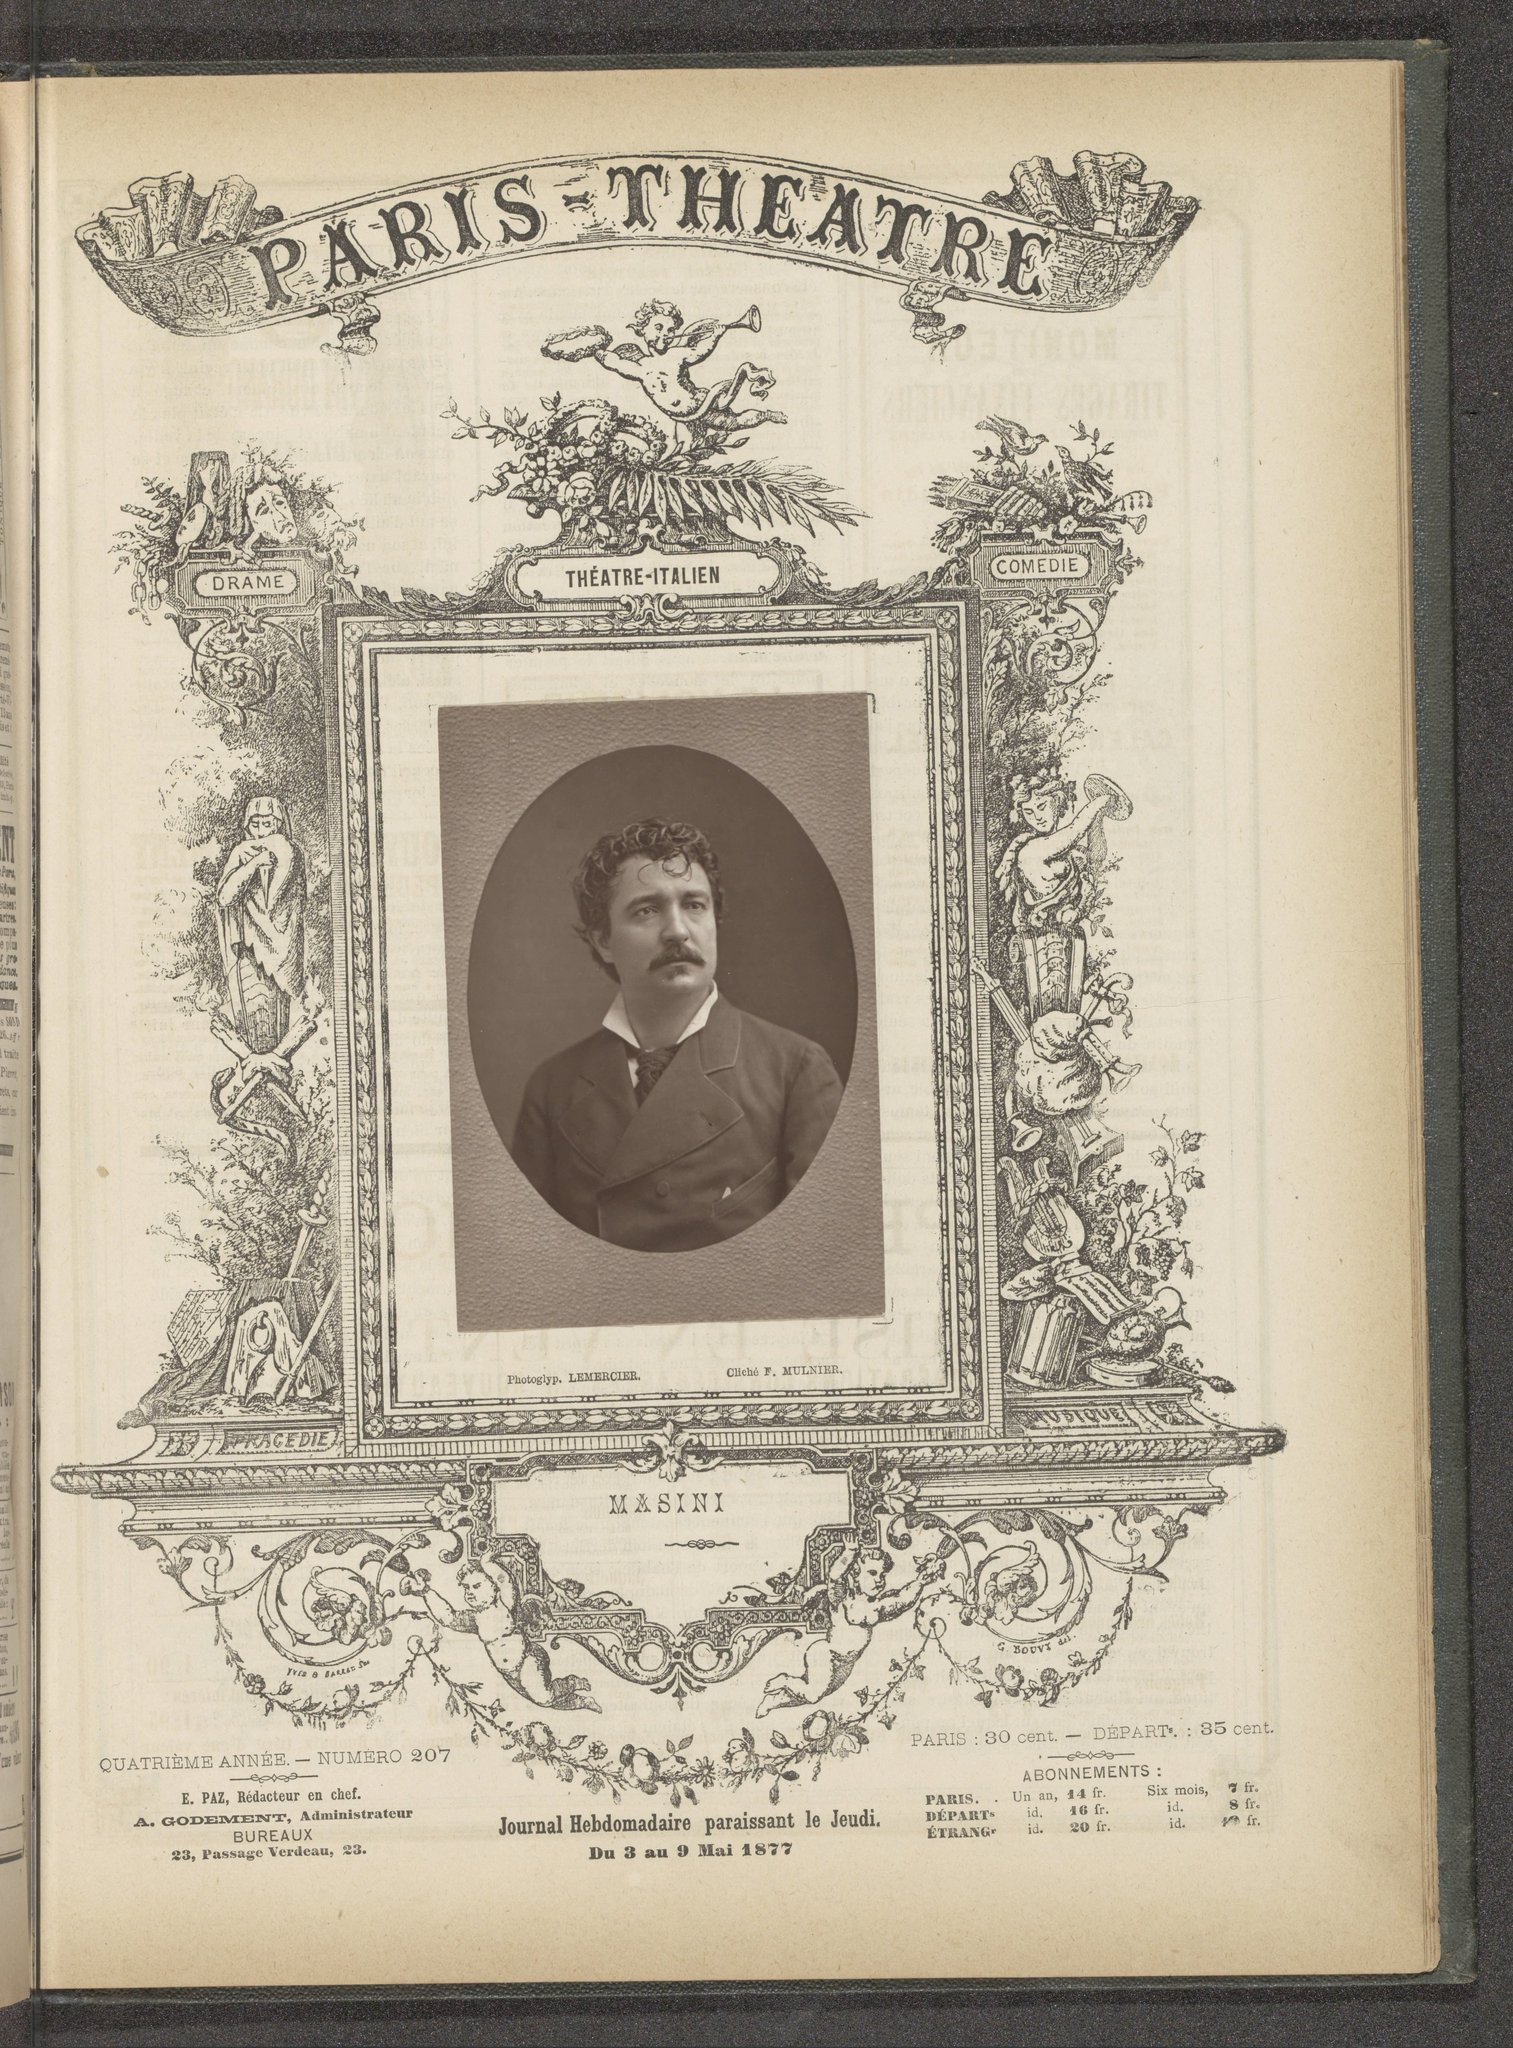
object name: photomechanical print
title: Portret van Angelo Masini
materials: paper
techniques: woodburytype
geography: france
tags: portrait of opera-singer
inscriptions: inscription: ‘Journal Hebdomadaire paraissant le Jeudi, Du 3 au 9 Mai 1877’, number: ‘Numéro 207’